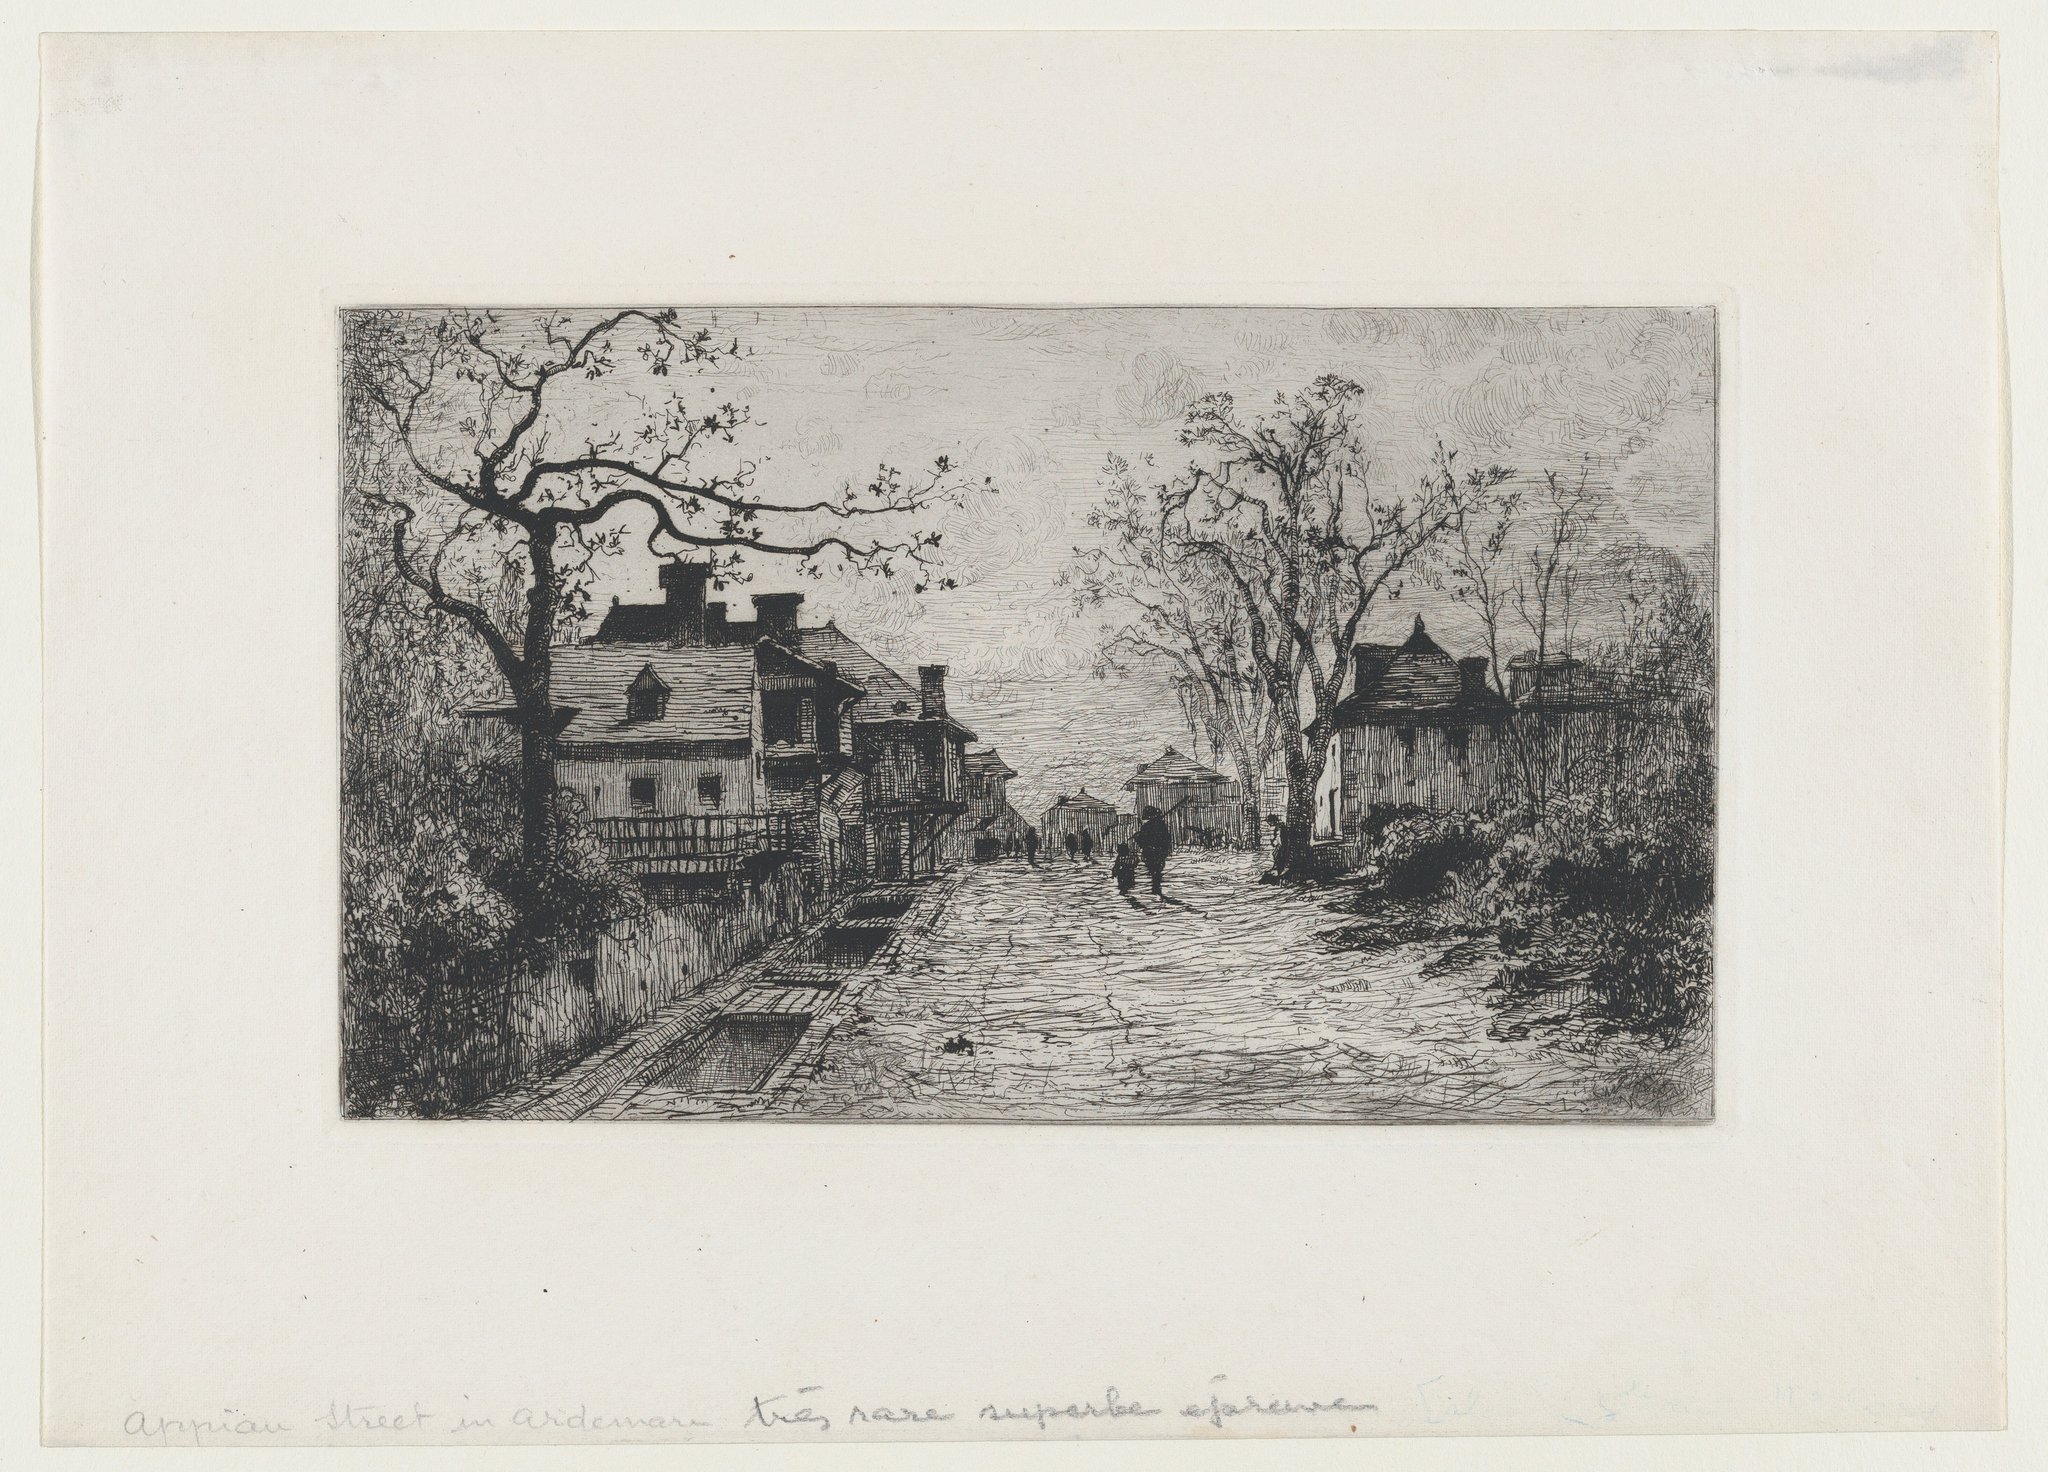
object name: print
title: Village Street in Artemare (Ain)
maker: adolphe appian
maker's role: artist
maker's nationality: french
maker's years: 1818-1898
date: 1871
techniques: etching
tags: houses,streets,villages